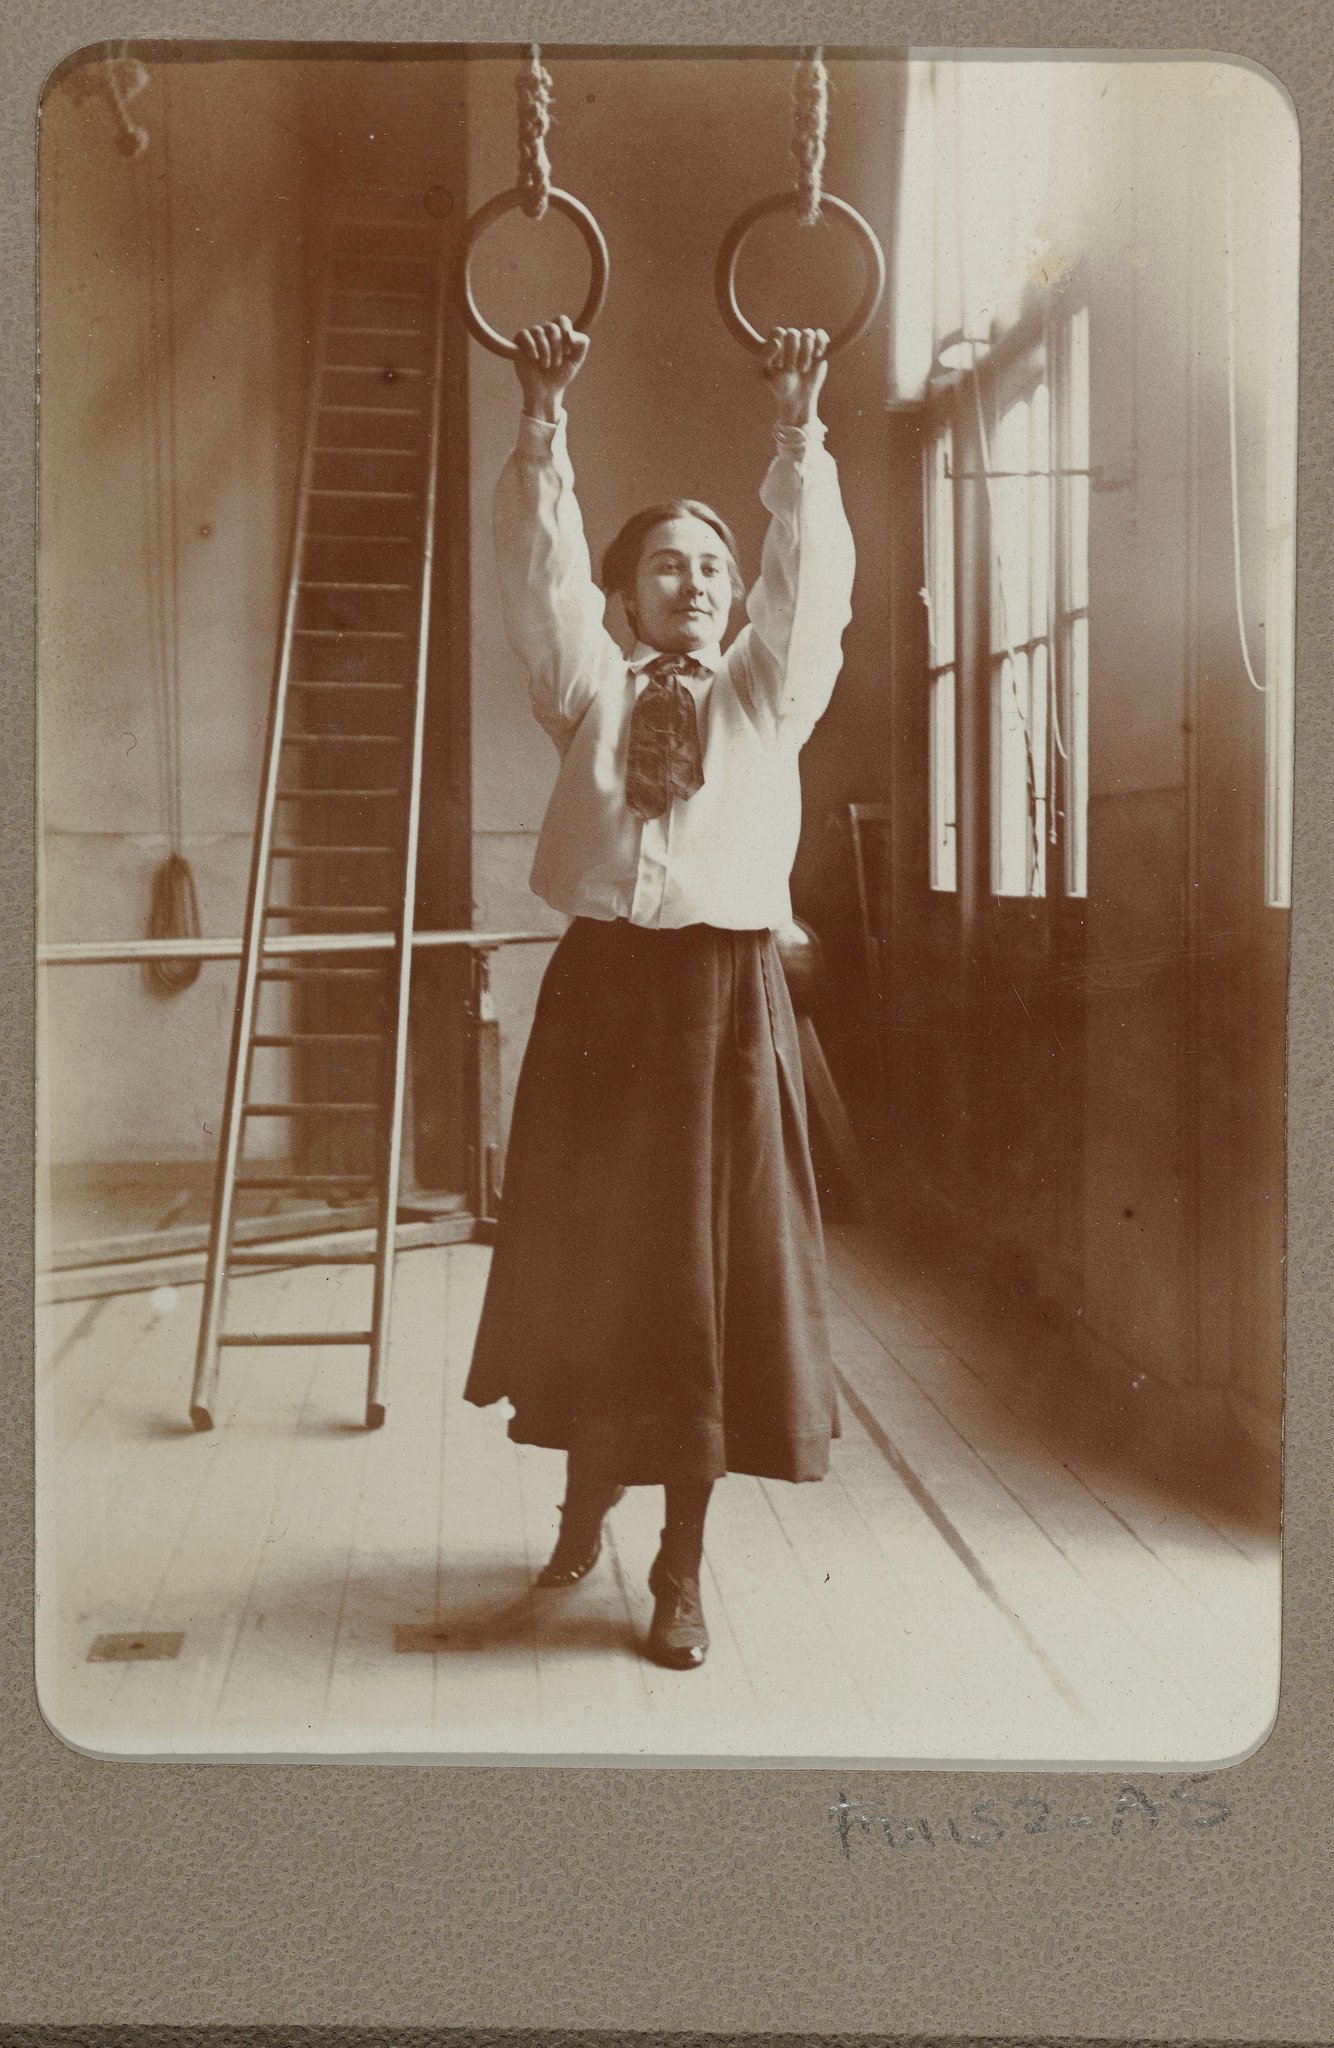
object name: photograph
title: Portret van een vrouw in een gymnastiekruimte, staande aan de ringen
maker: christiaan otto roelofs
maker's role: fotograaf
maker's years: 1882-1970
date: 1900-1915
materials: photographic support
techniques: gelatin silver print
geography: netherlands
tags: historical persons - bb - woman, rings (gymnastics)